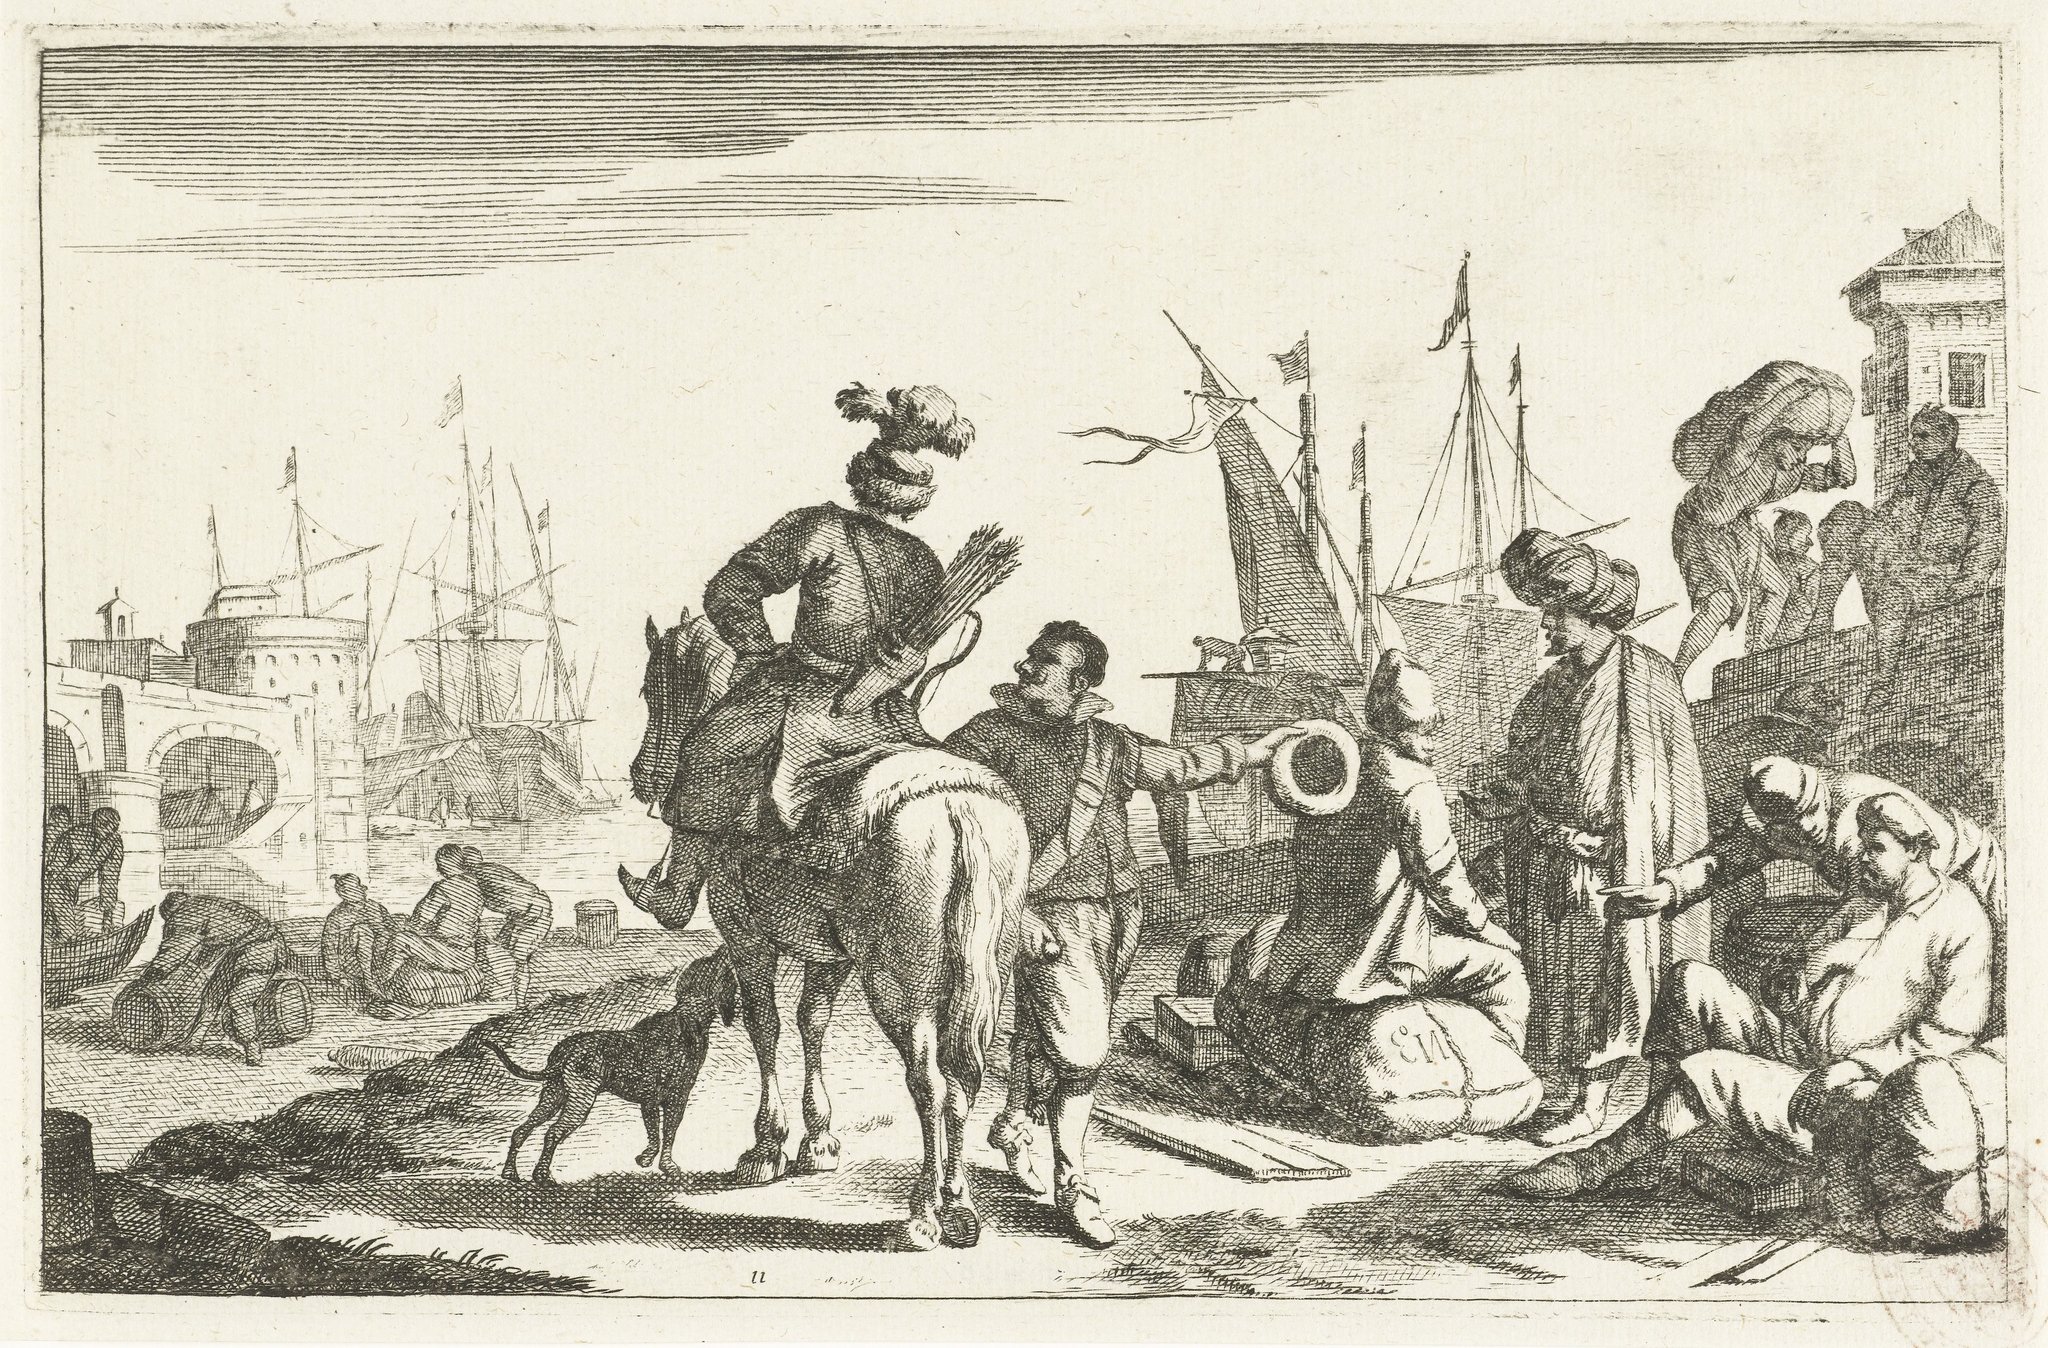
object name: print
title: Italiaanse havens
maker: johannes gronsveld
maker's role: draughtsman, painter, print maker, publisher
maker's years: 1658-1728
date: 1679-1728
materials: paper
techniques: engraving, etching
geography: amsterdam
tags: harbour (+ four persons or more ~ traffic and transport)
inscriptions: collector's mark: Lugt 240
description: Haven met op de voorgrond een ruiter met pijlenkoker op de rug, in gesprek met een man. Bij hen zit een hond. Links en rechts groepen kooplieden. Zeilschepen op de achtergrond. Elfde prent uit een serie van twaalf met Italiaanse havens.